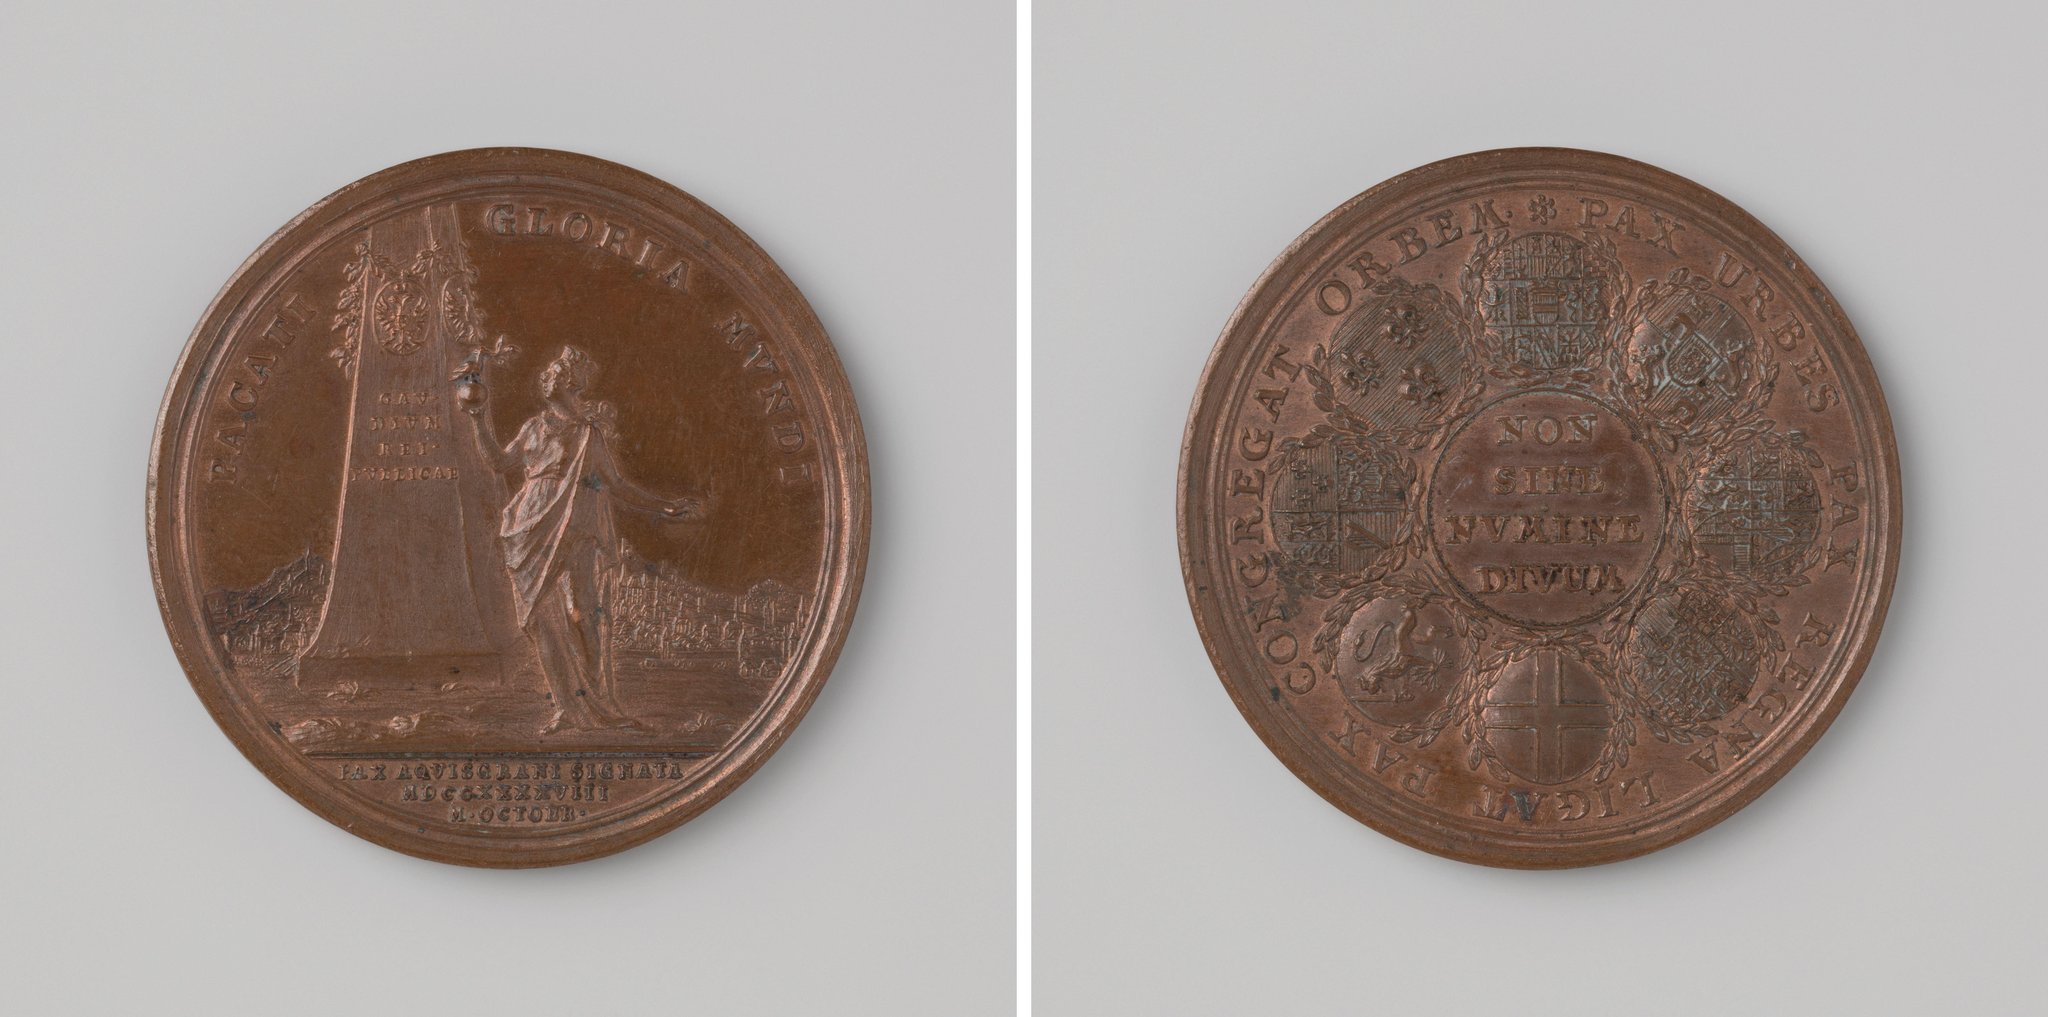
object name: history medal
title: Vrede te Aken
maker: Anonymous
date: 1748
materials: bronze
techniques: striking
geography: aachen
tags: aken, vrede van aken (1748)